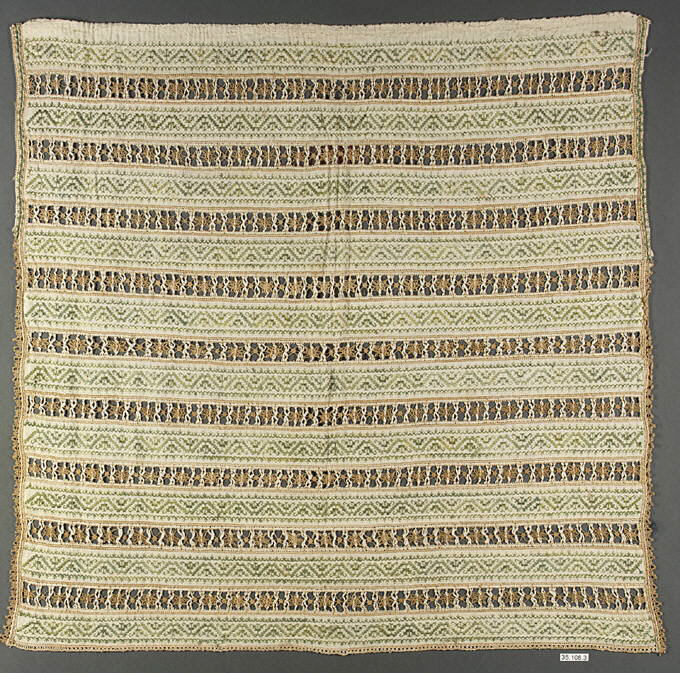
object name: panel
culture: mexican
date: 1801-1900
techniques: embroidery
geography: mexico